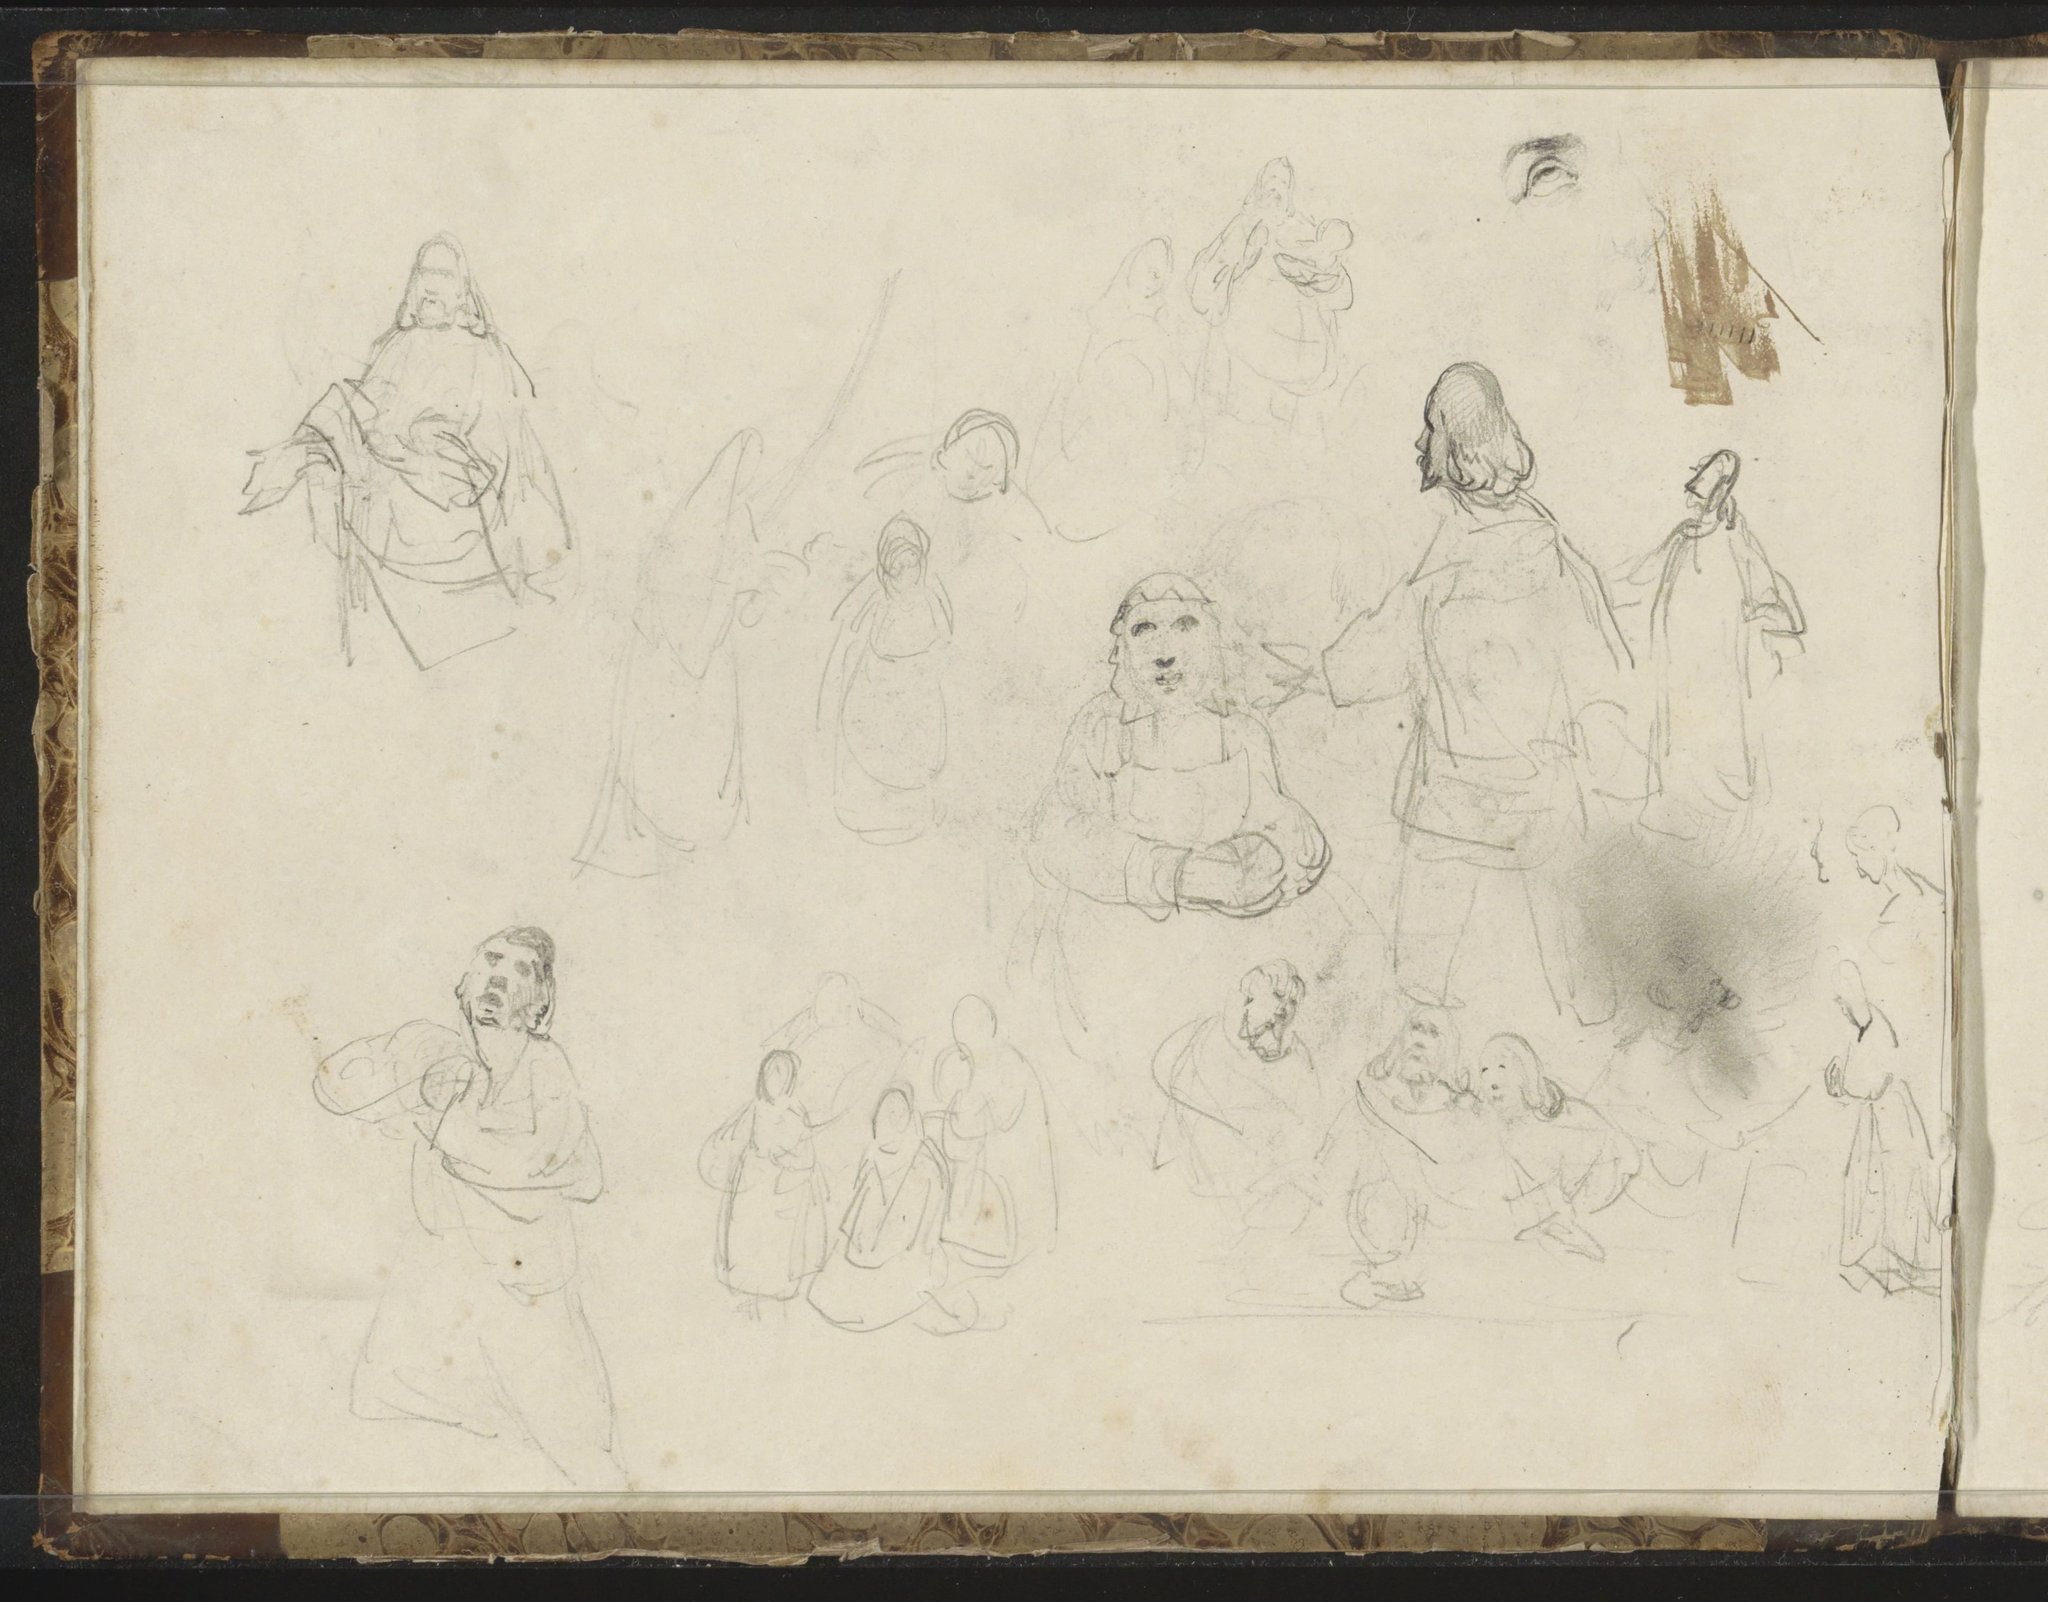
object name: sketchbook leaf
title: Studieblad met figuren en Christus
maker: willem hendrik schmidt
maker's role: draughtsman, painter, print maker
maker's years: 1809-1849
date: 1819-1849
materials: paper, pencil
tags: movements of the human body, christ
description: Blad 1 verso uit een schetsboek met 52 bladen.